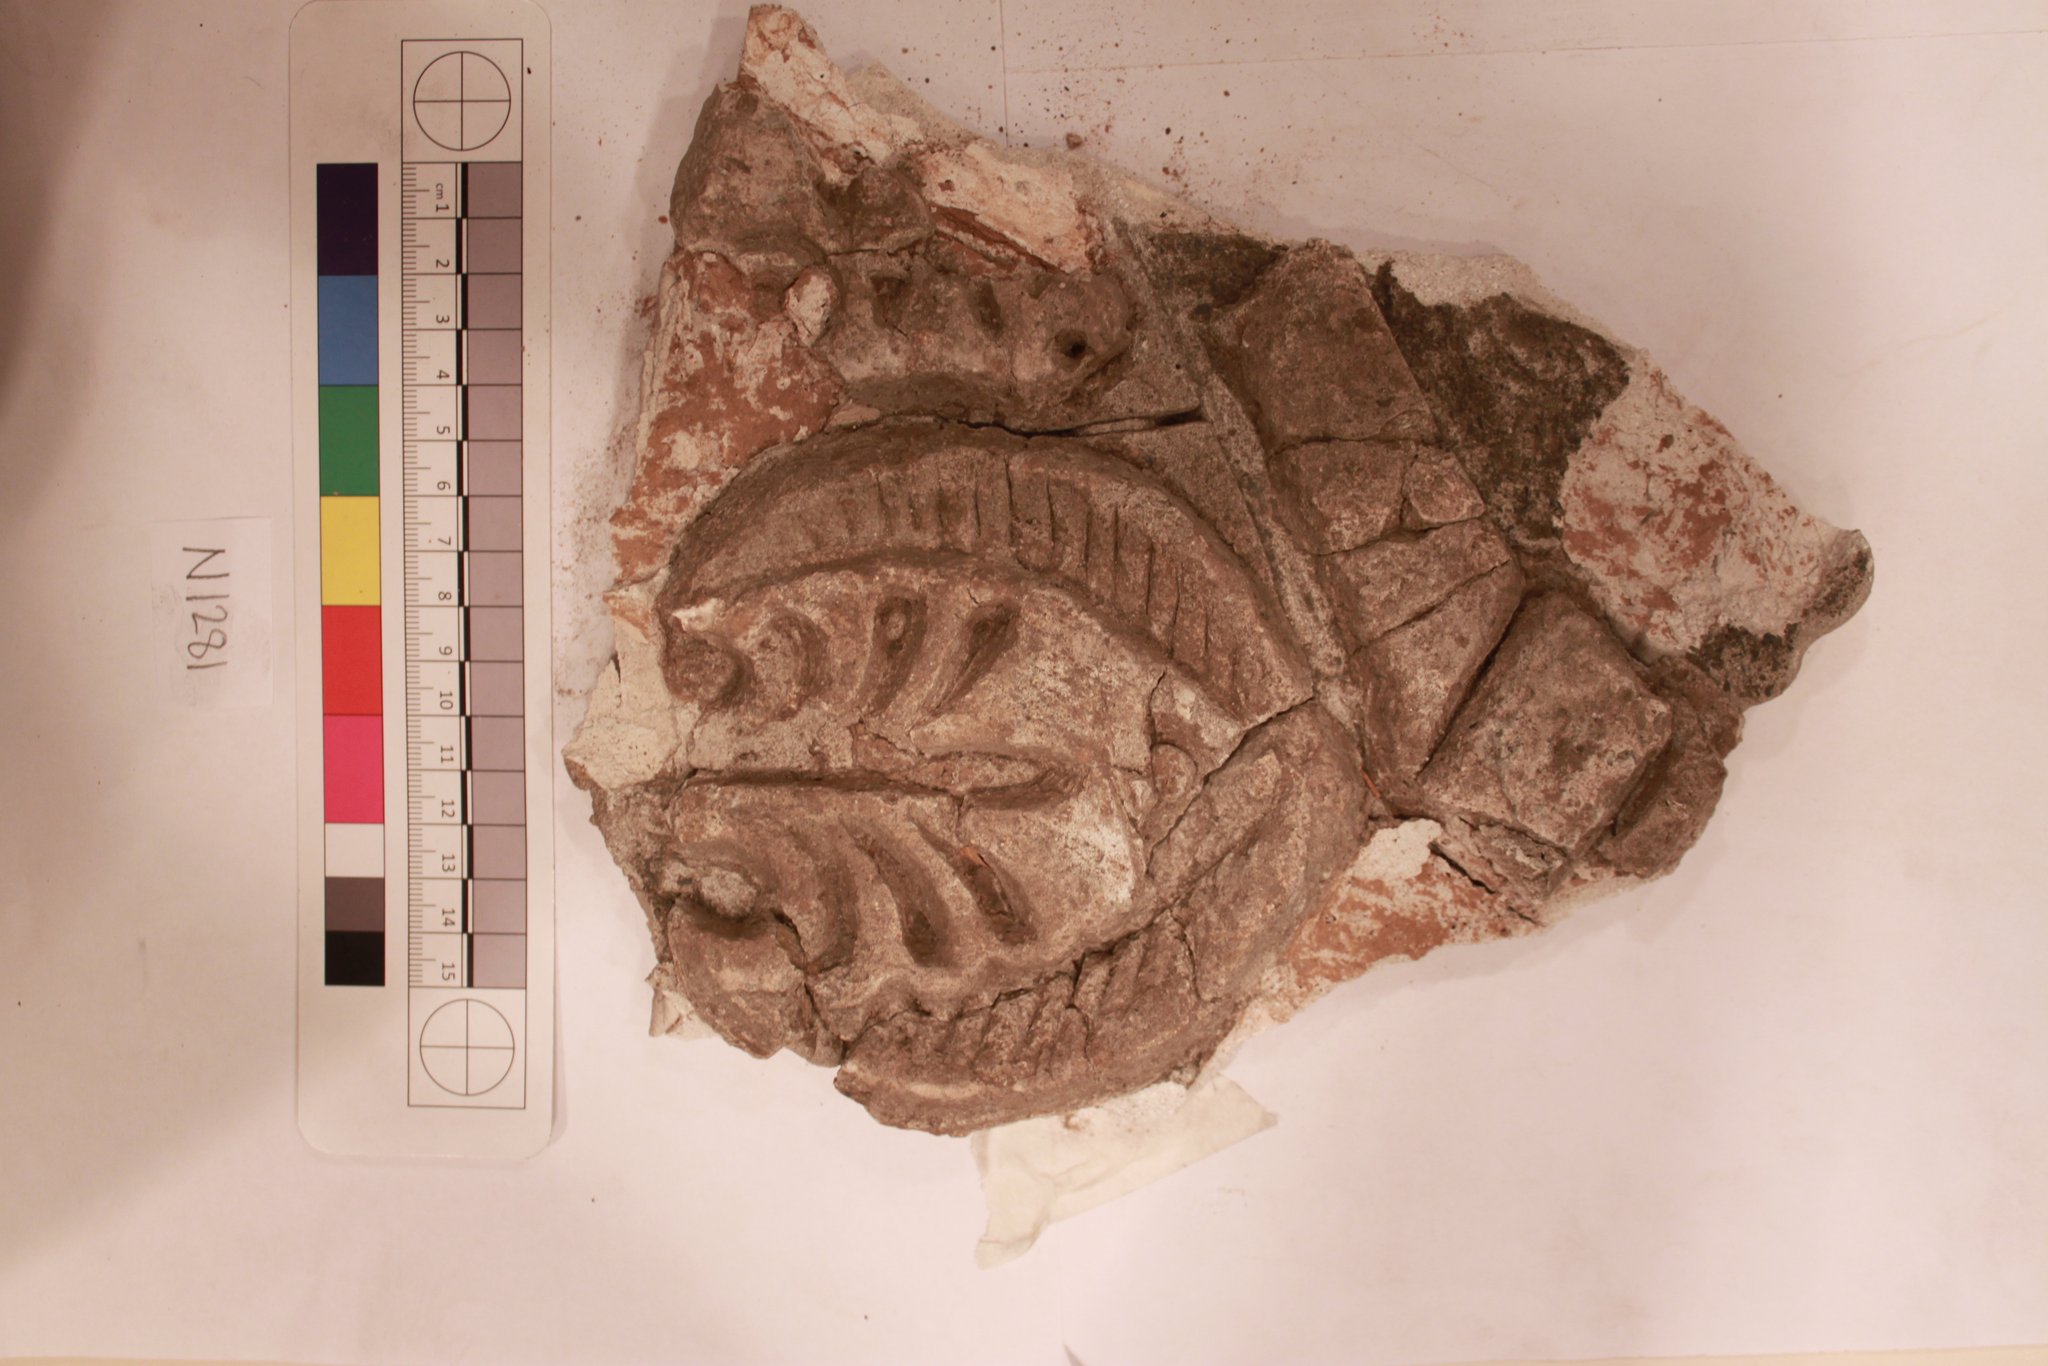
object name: fragment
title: Stucco Fragment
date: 701-1200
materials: plaster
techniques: carving, painting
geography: iran